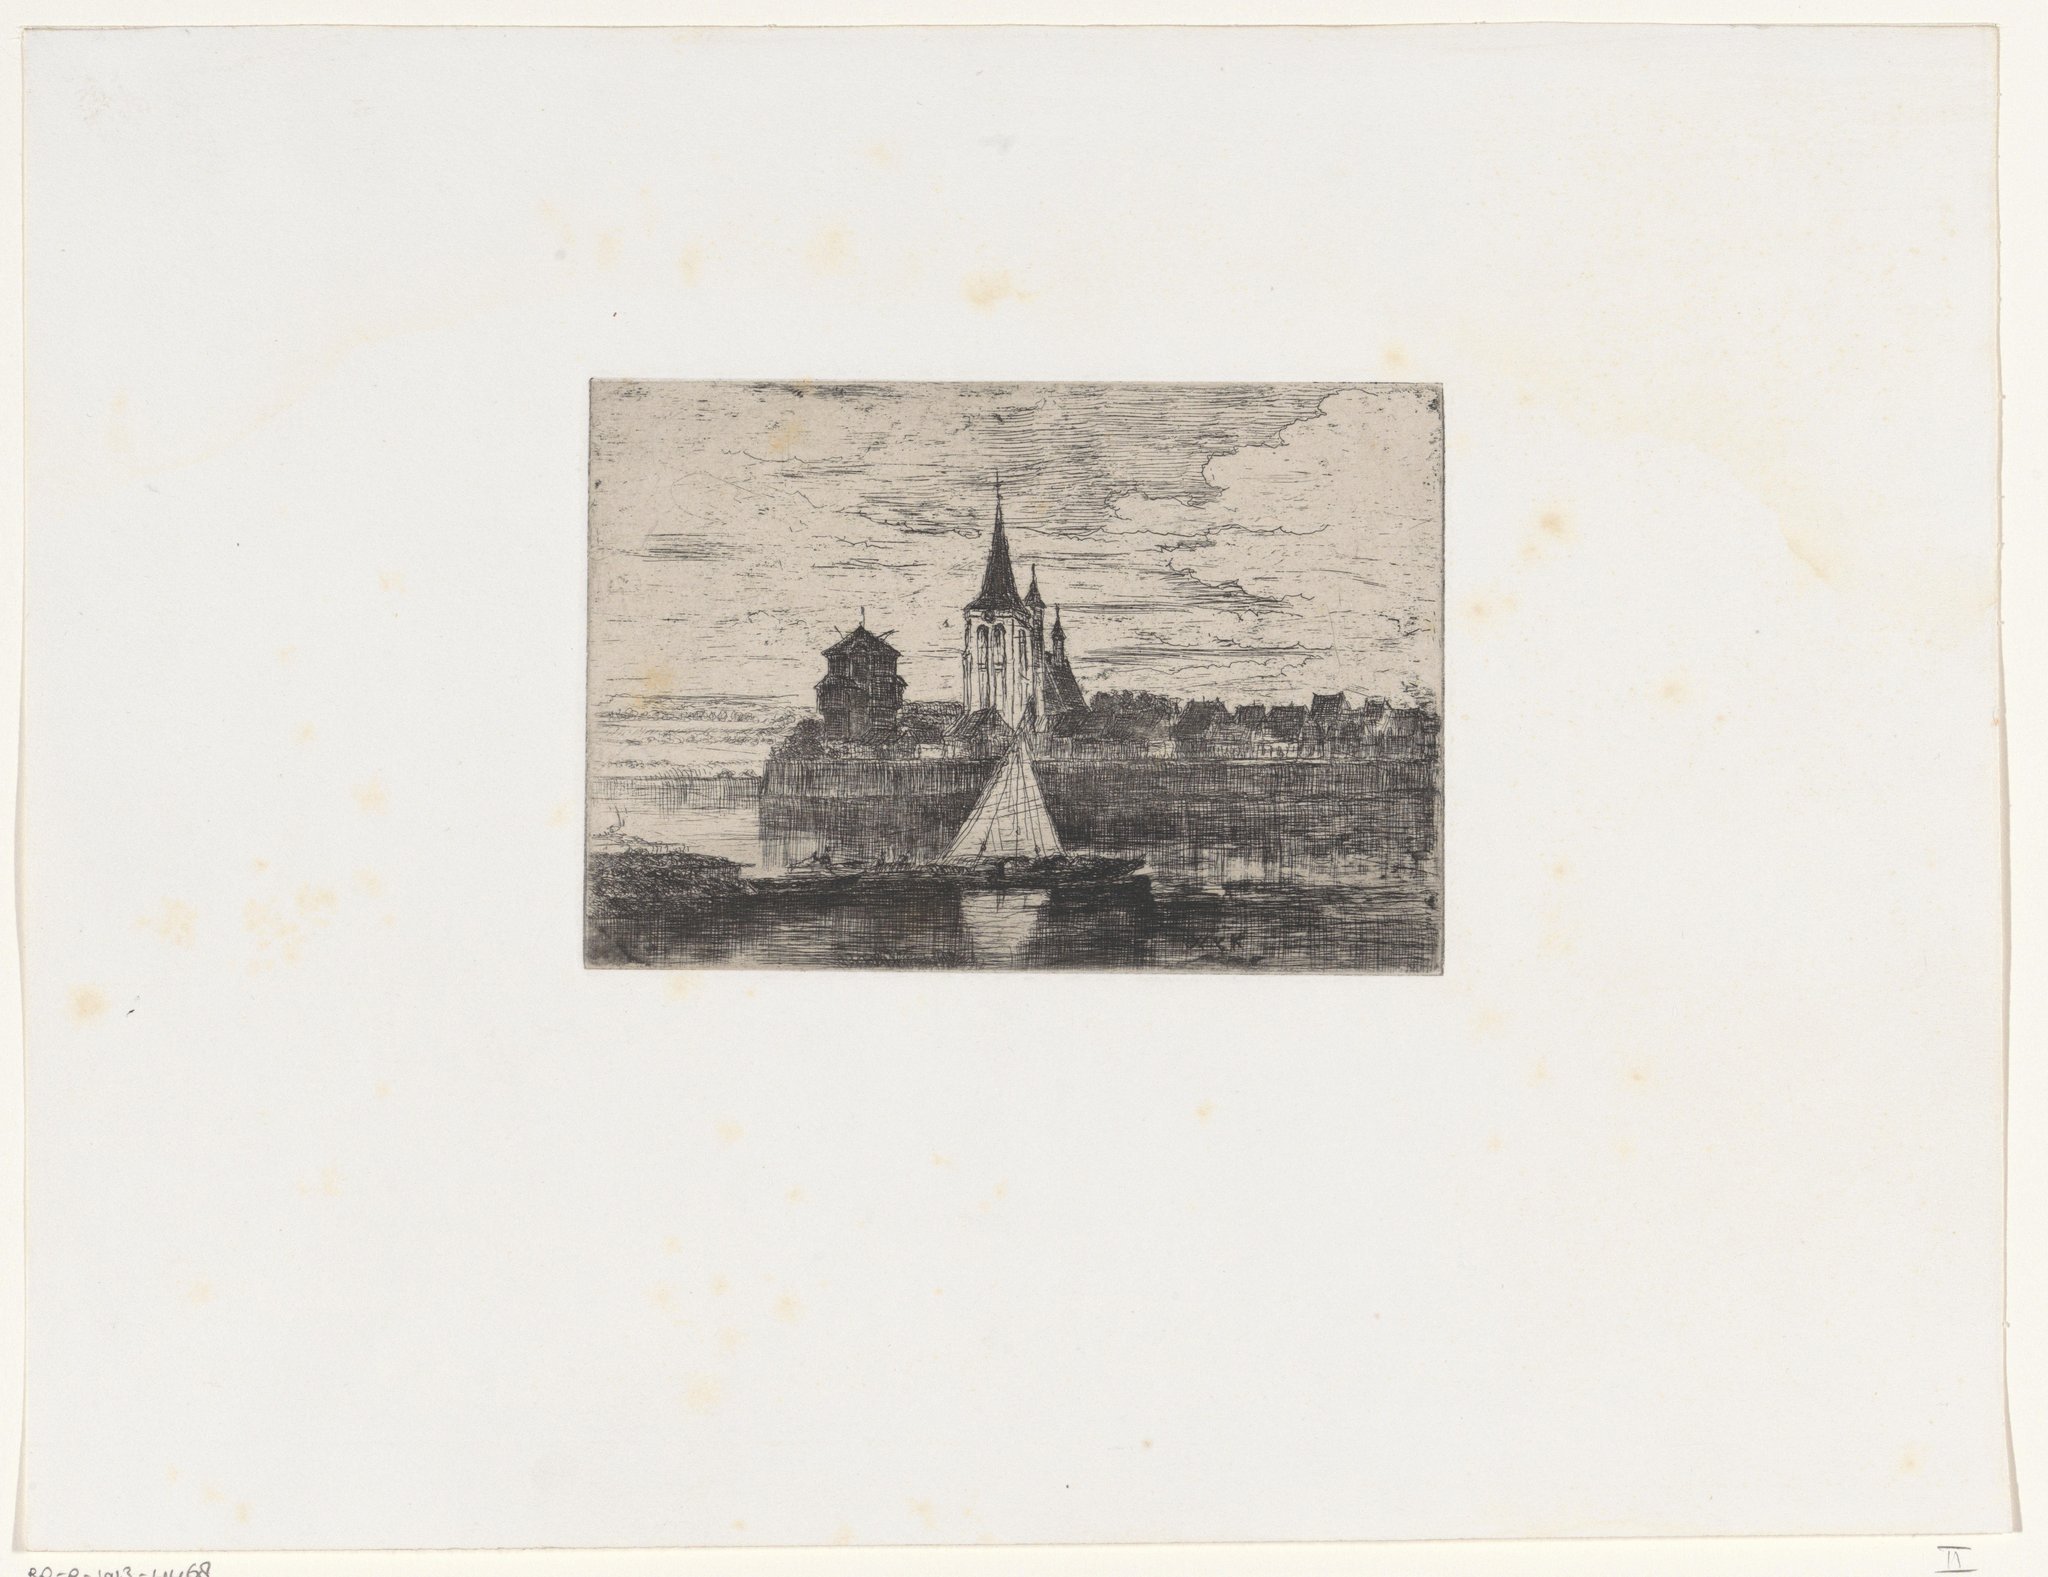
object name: print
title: Gezicht op een dorp aan het water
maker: alexander schaepkens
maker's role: draughtsman, print maker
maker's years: 1815-1899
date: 1840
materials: paper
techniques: etching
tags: sailing-ship, sailing-boat, landscapes with waters, waterscapes, seascapes (in the temperate zone), church (exterior)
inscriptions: collector's mark: Lugt 2228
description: Langs de Maasoever loopt de stadsmuur. Op de wal de Wycker Kruittoren, afgebroken in december 1868, en de middeleeuwse Sint Martinuskerk, afgebroken in 1855.